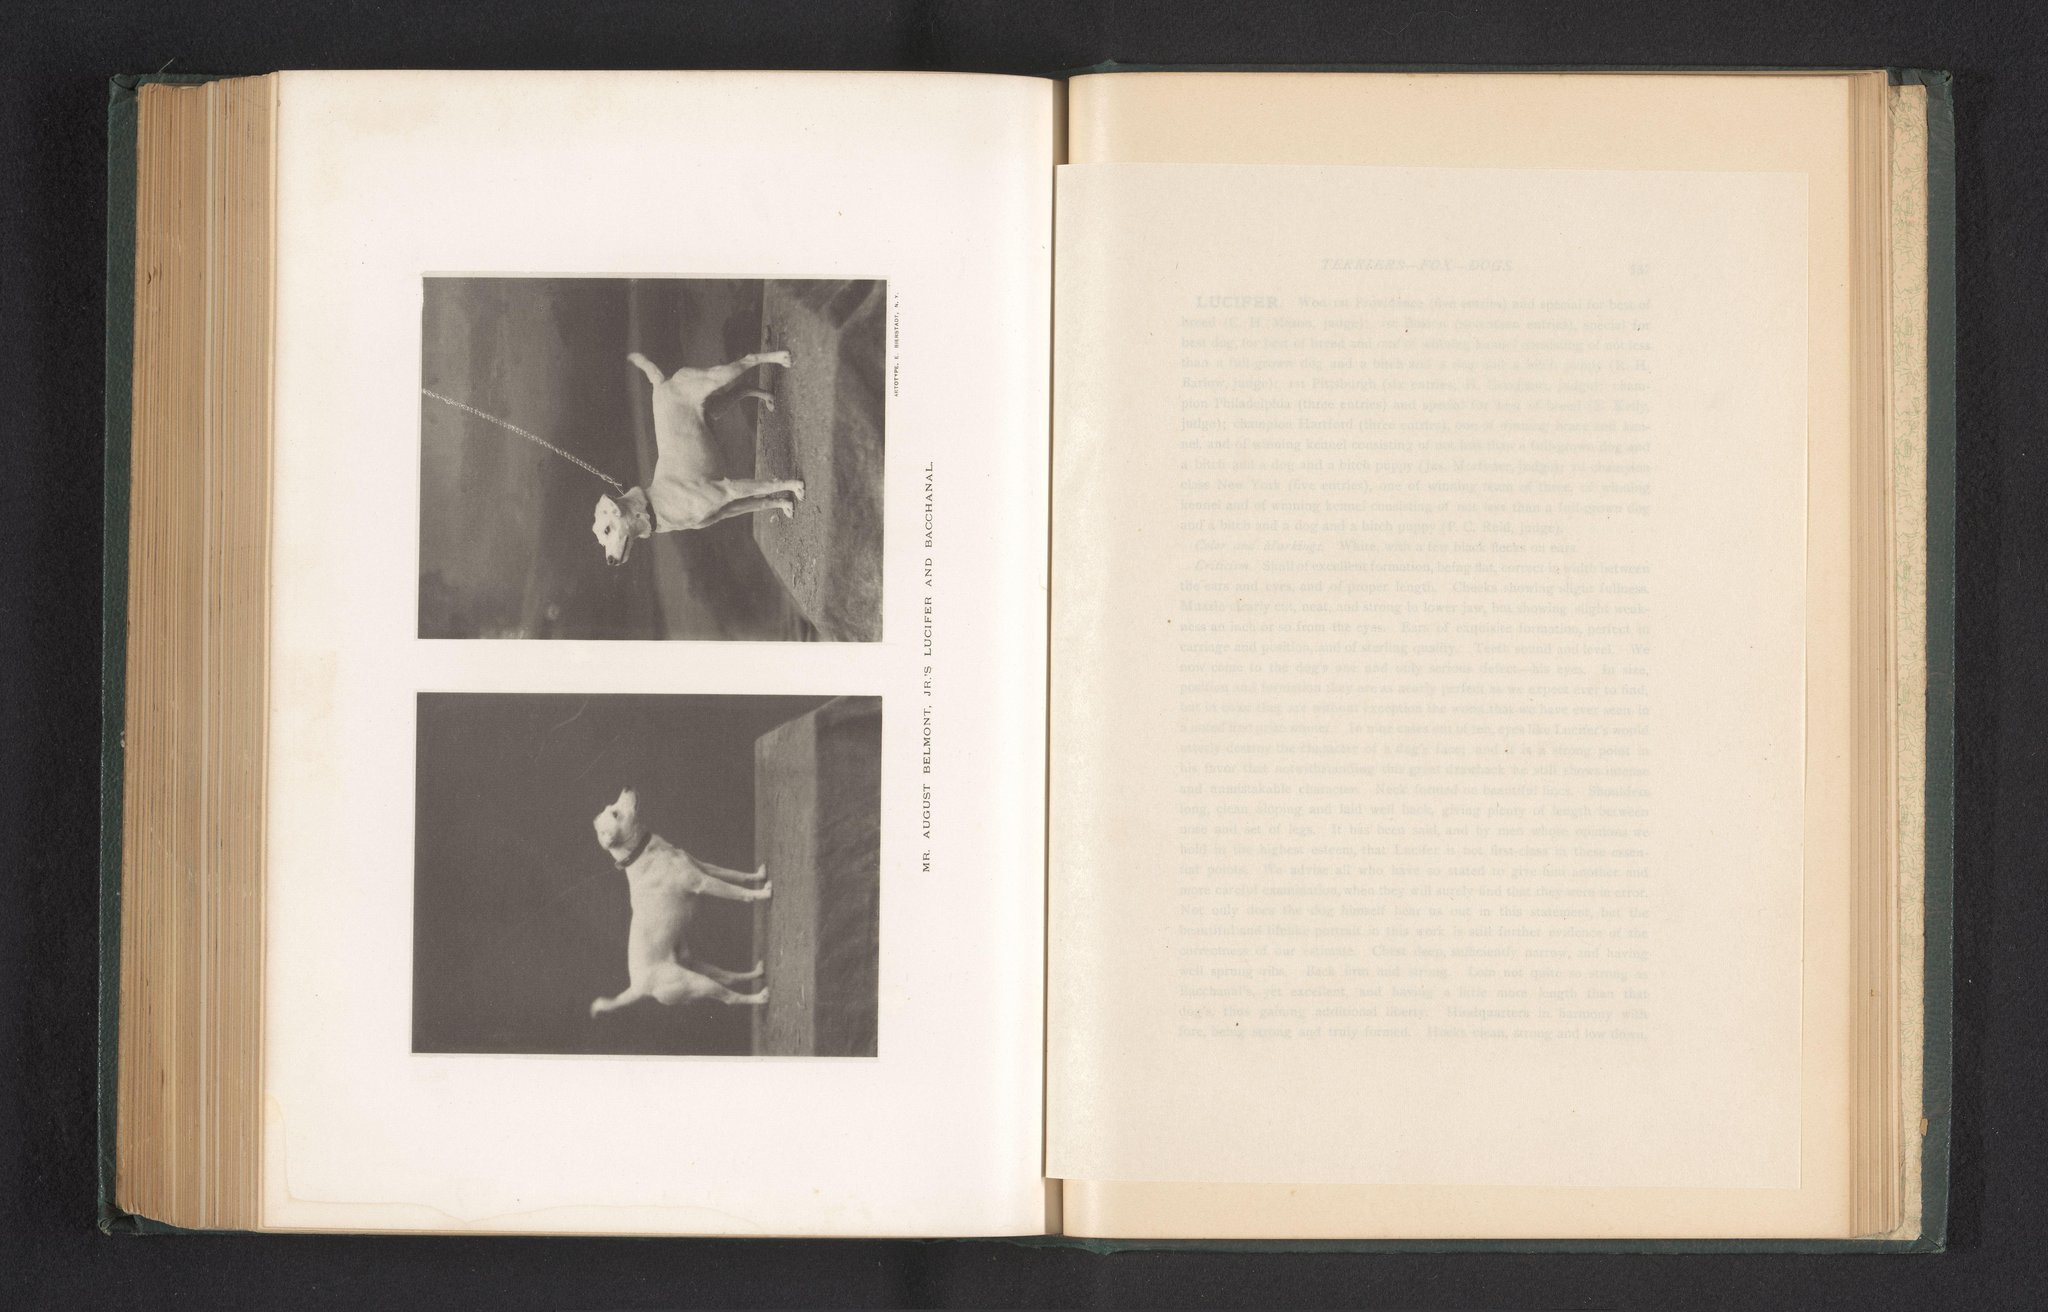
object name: page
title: Foxterriër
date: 1883-1888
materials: paper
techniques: photograph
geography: new york city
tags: dog (foxterrier)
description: Prent tegenover pagina 537, achter semi-transparante omslag.